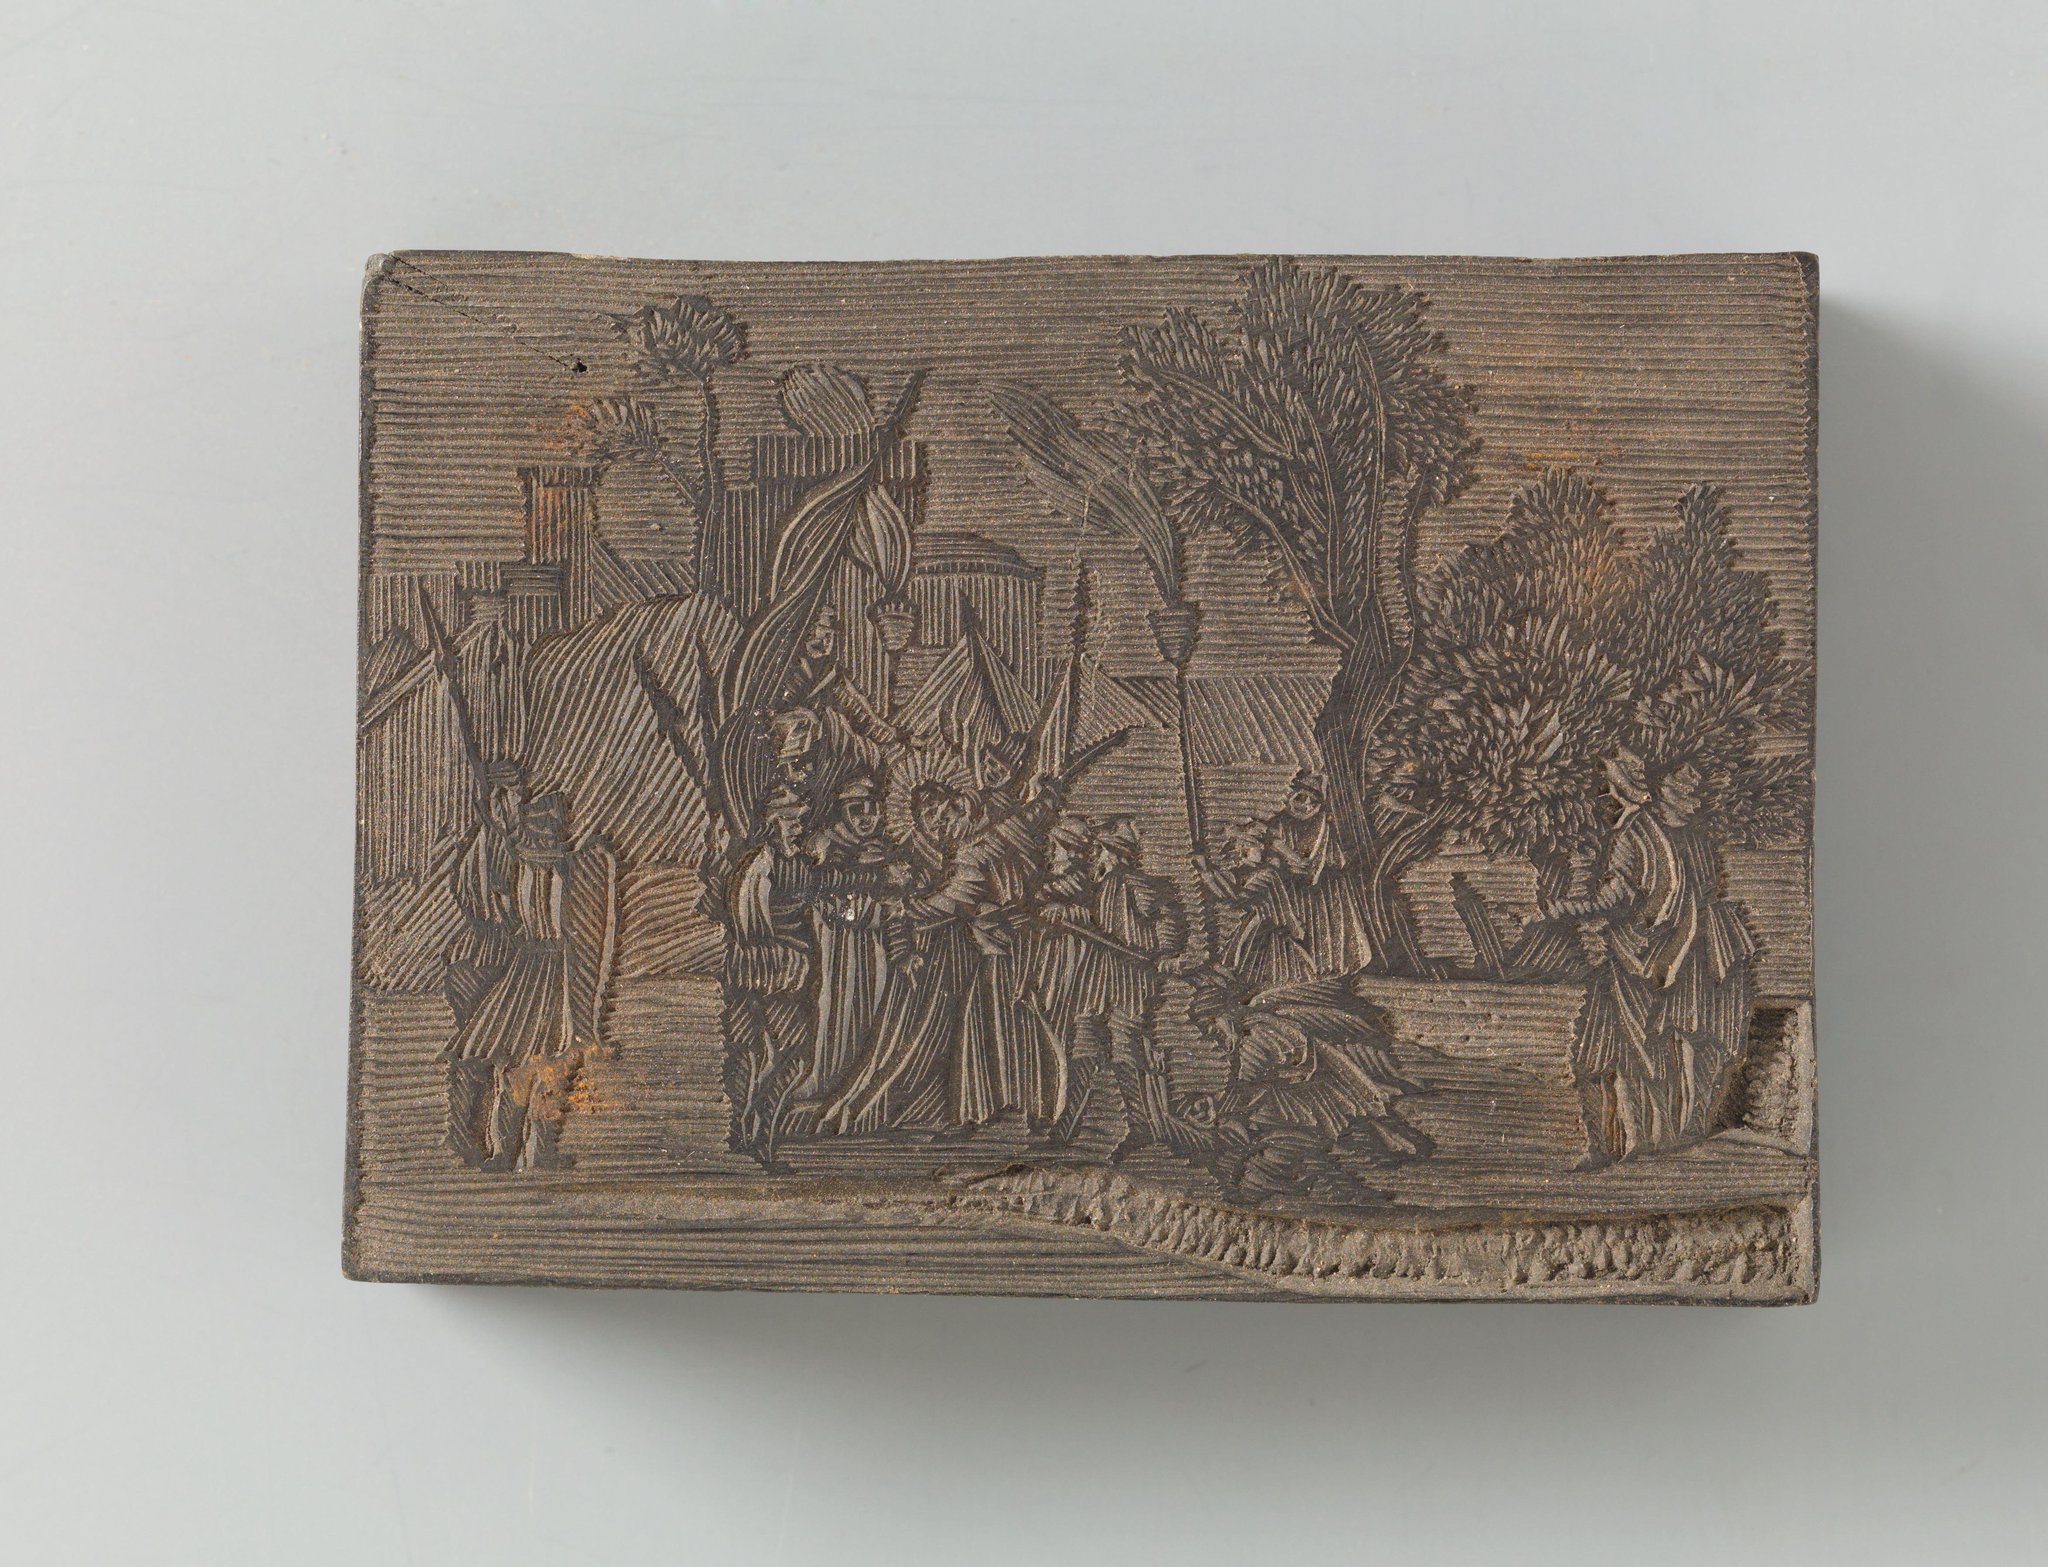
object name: wood block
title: Bijbel-illustraties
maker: Anonymous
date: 1550-1699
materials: wood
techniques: woodcut